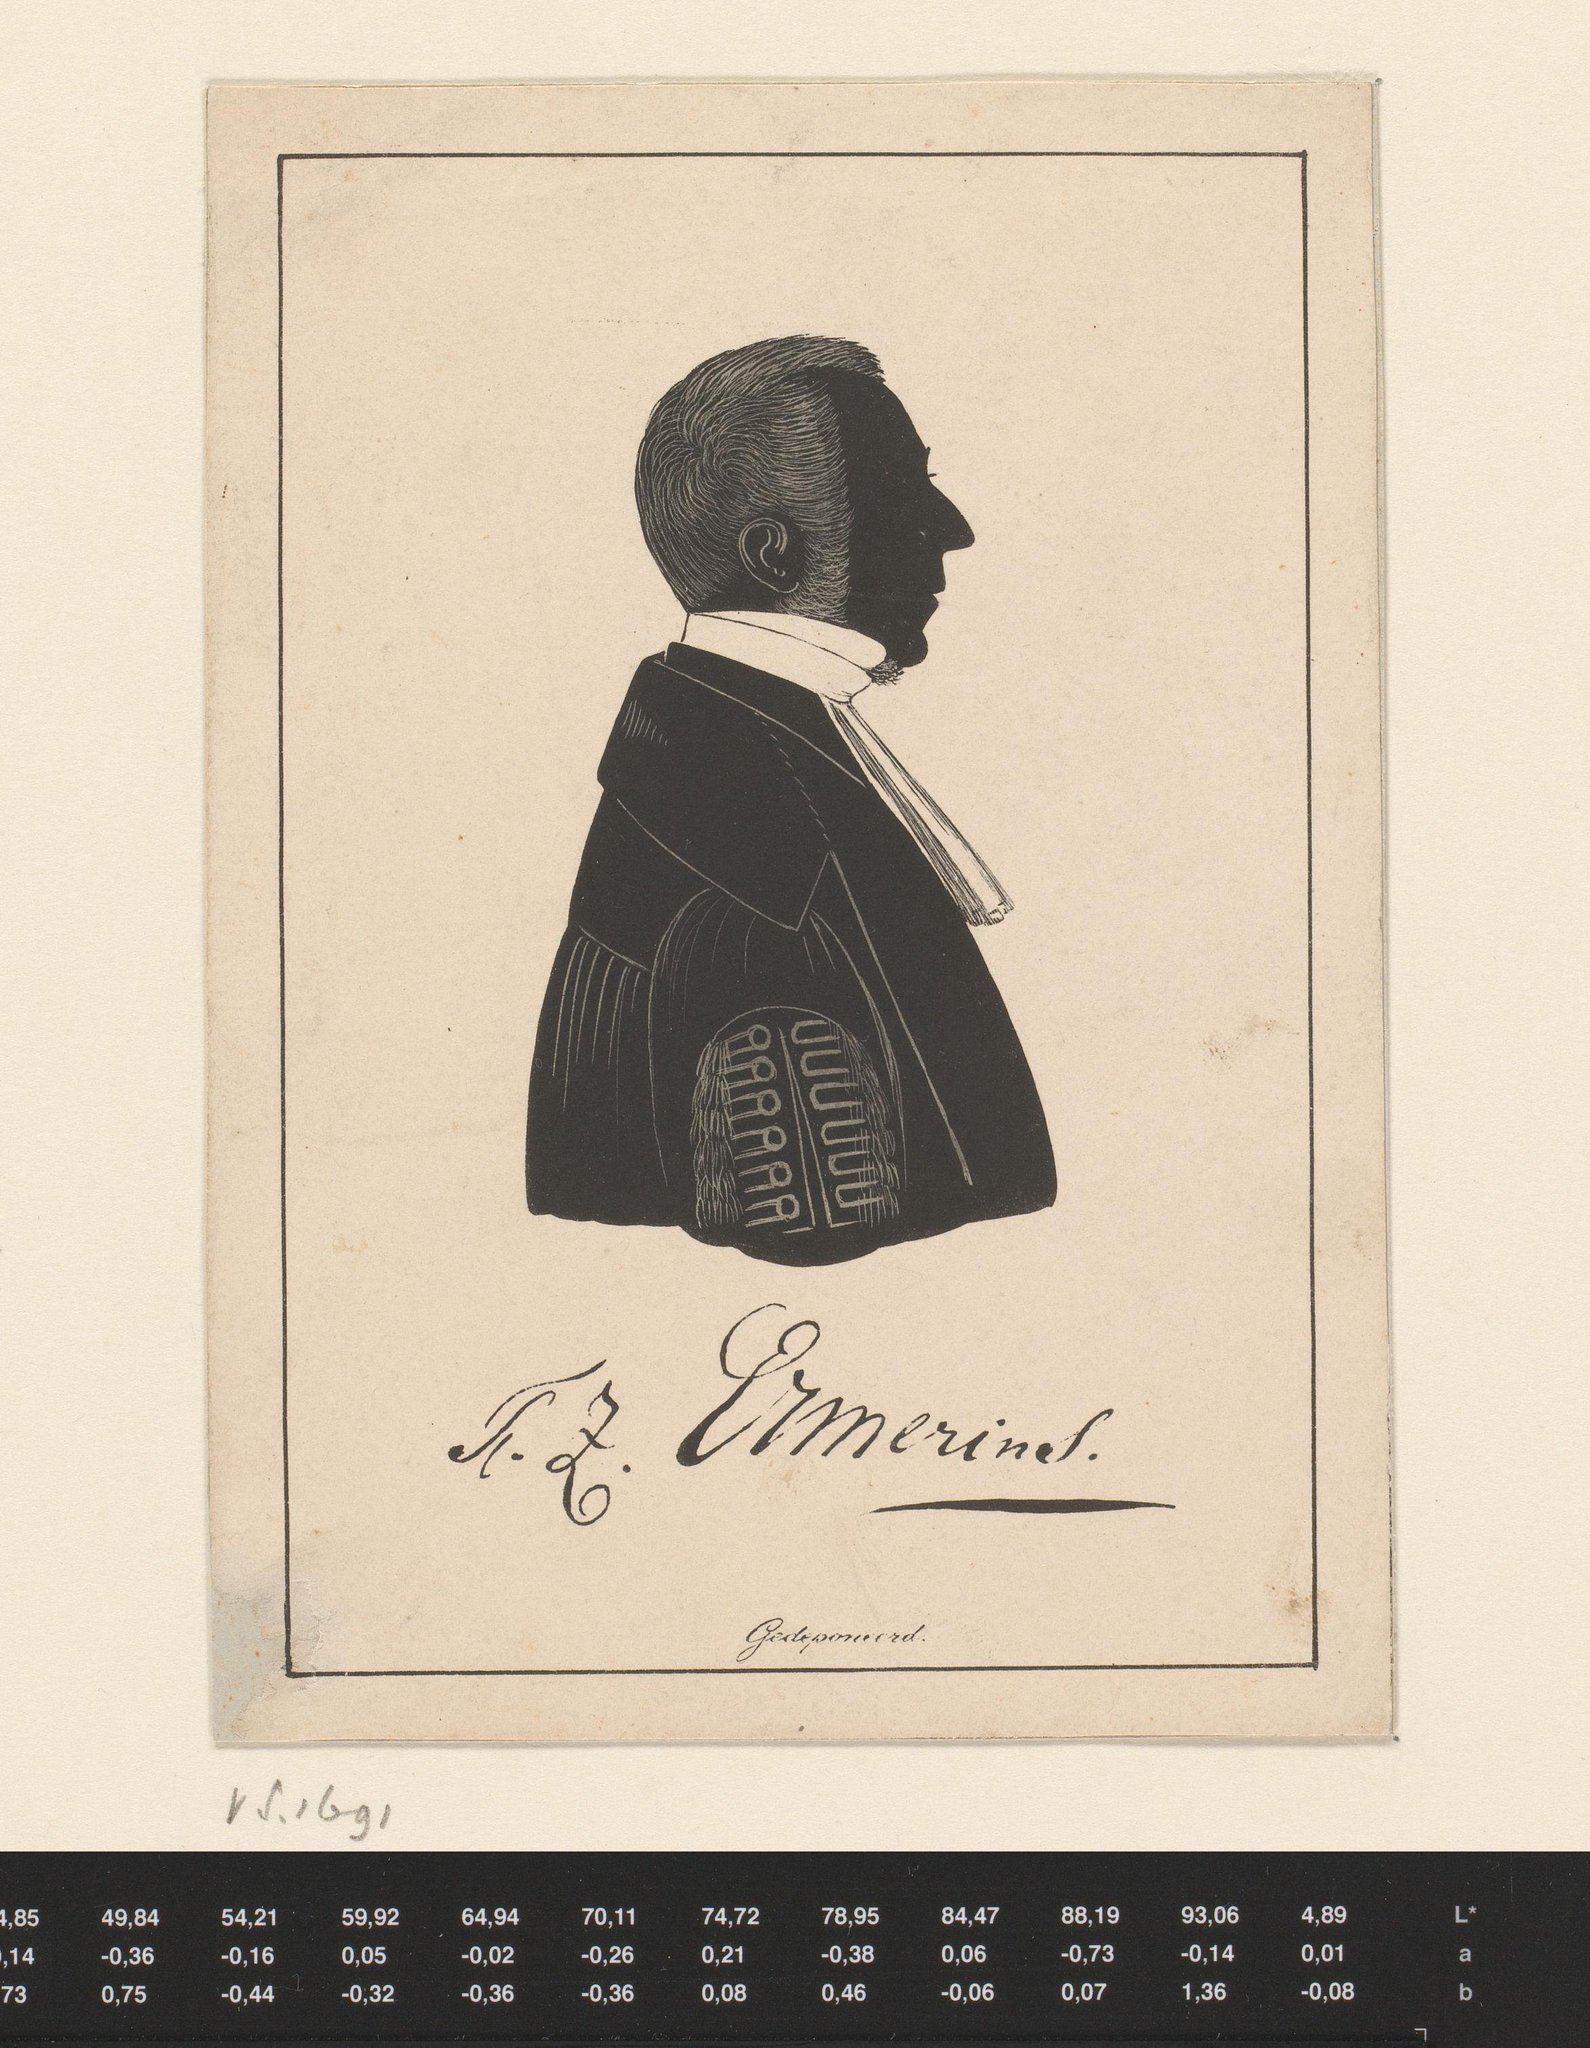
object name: print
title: Silhouetportret van François Zacharias Ermerins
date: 1848-1862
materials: paper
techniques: hand coloring, lithograph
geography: zwolle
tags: middelburg, historical persons, professor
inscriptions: : ‘Gedeponeerd.’, collector's mark: Lugt 2228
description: Met facsimile handtekening van de geportretteerde.